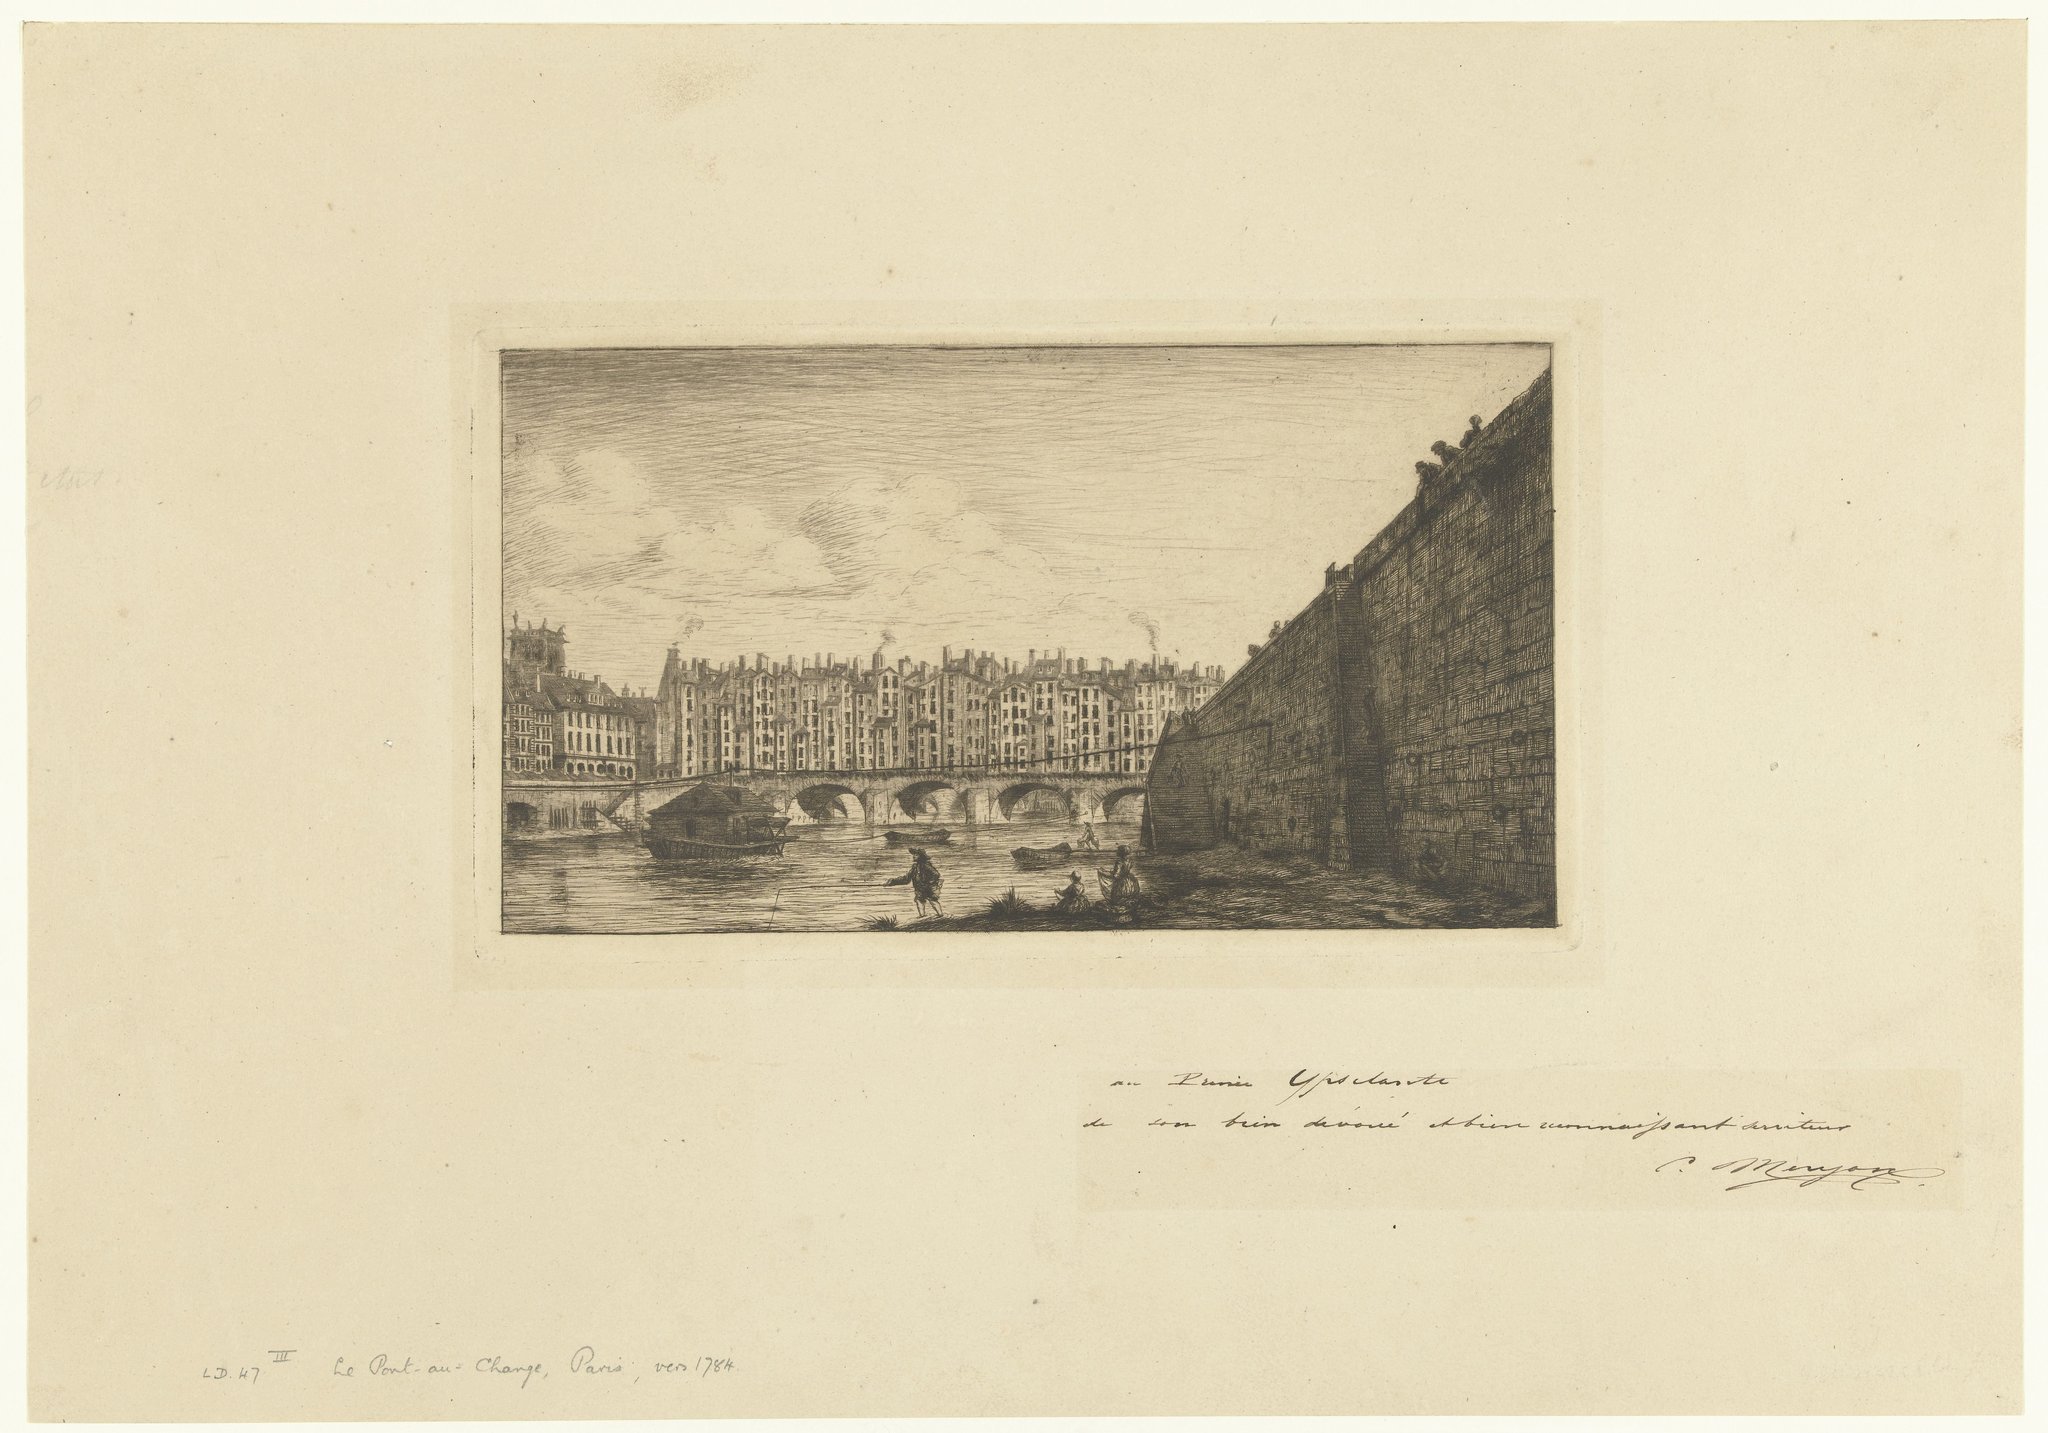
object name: print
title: Le Pont-au-Change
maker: charles meryon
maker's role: print maker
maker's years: 1821-1868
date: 1854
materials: paper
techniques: drypoint, etching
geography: paris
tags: bridge in city across river, canal, etc.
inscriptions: collector's mark:, collector's mark: Lugt 2228, dedication: ‘au Prince Ypsilante/ de son bien dévoué et bien reconnaissant serviteur/ C. Meryon’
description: Prent naar aquarel van Jean Victor Nicolle. De kunstnaar heeft de originele compositie vrij nauwkeurig gevolgd. De situatie met de huizen op de brug bestond in 1786 al niet meer (De Groot 1991, p. 66).